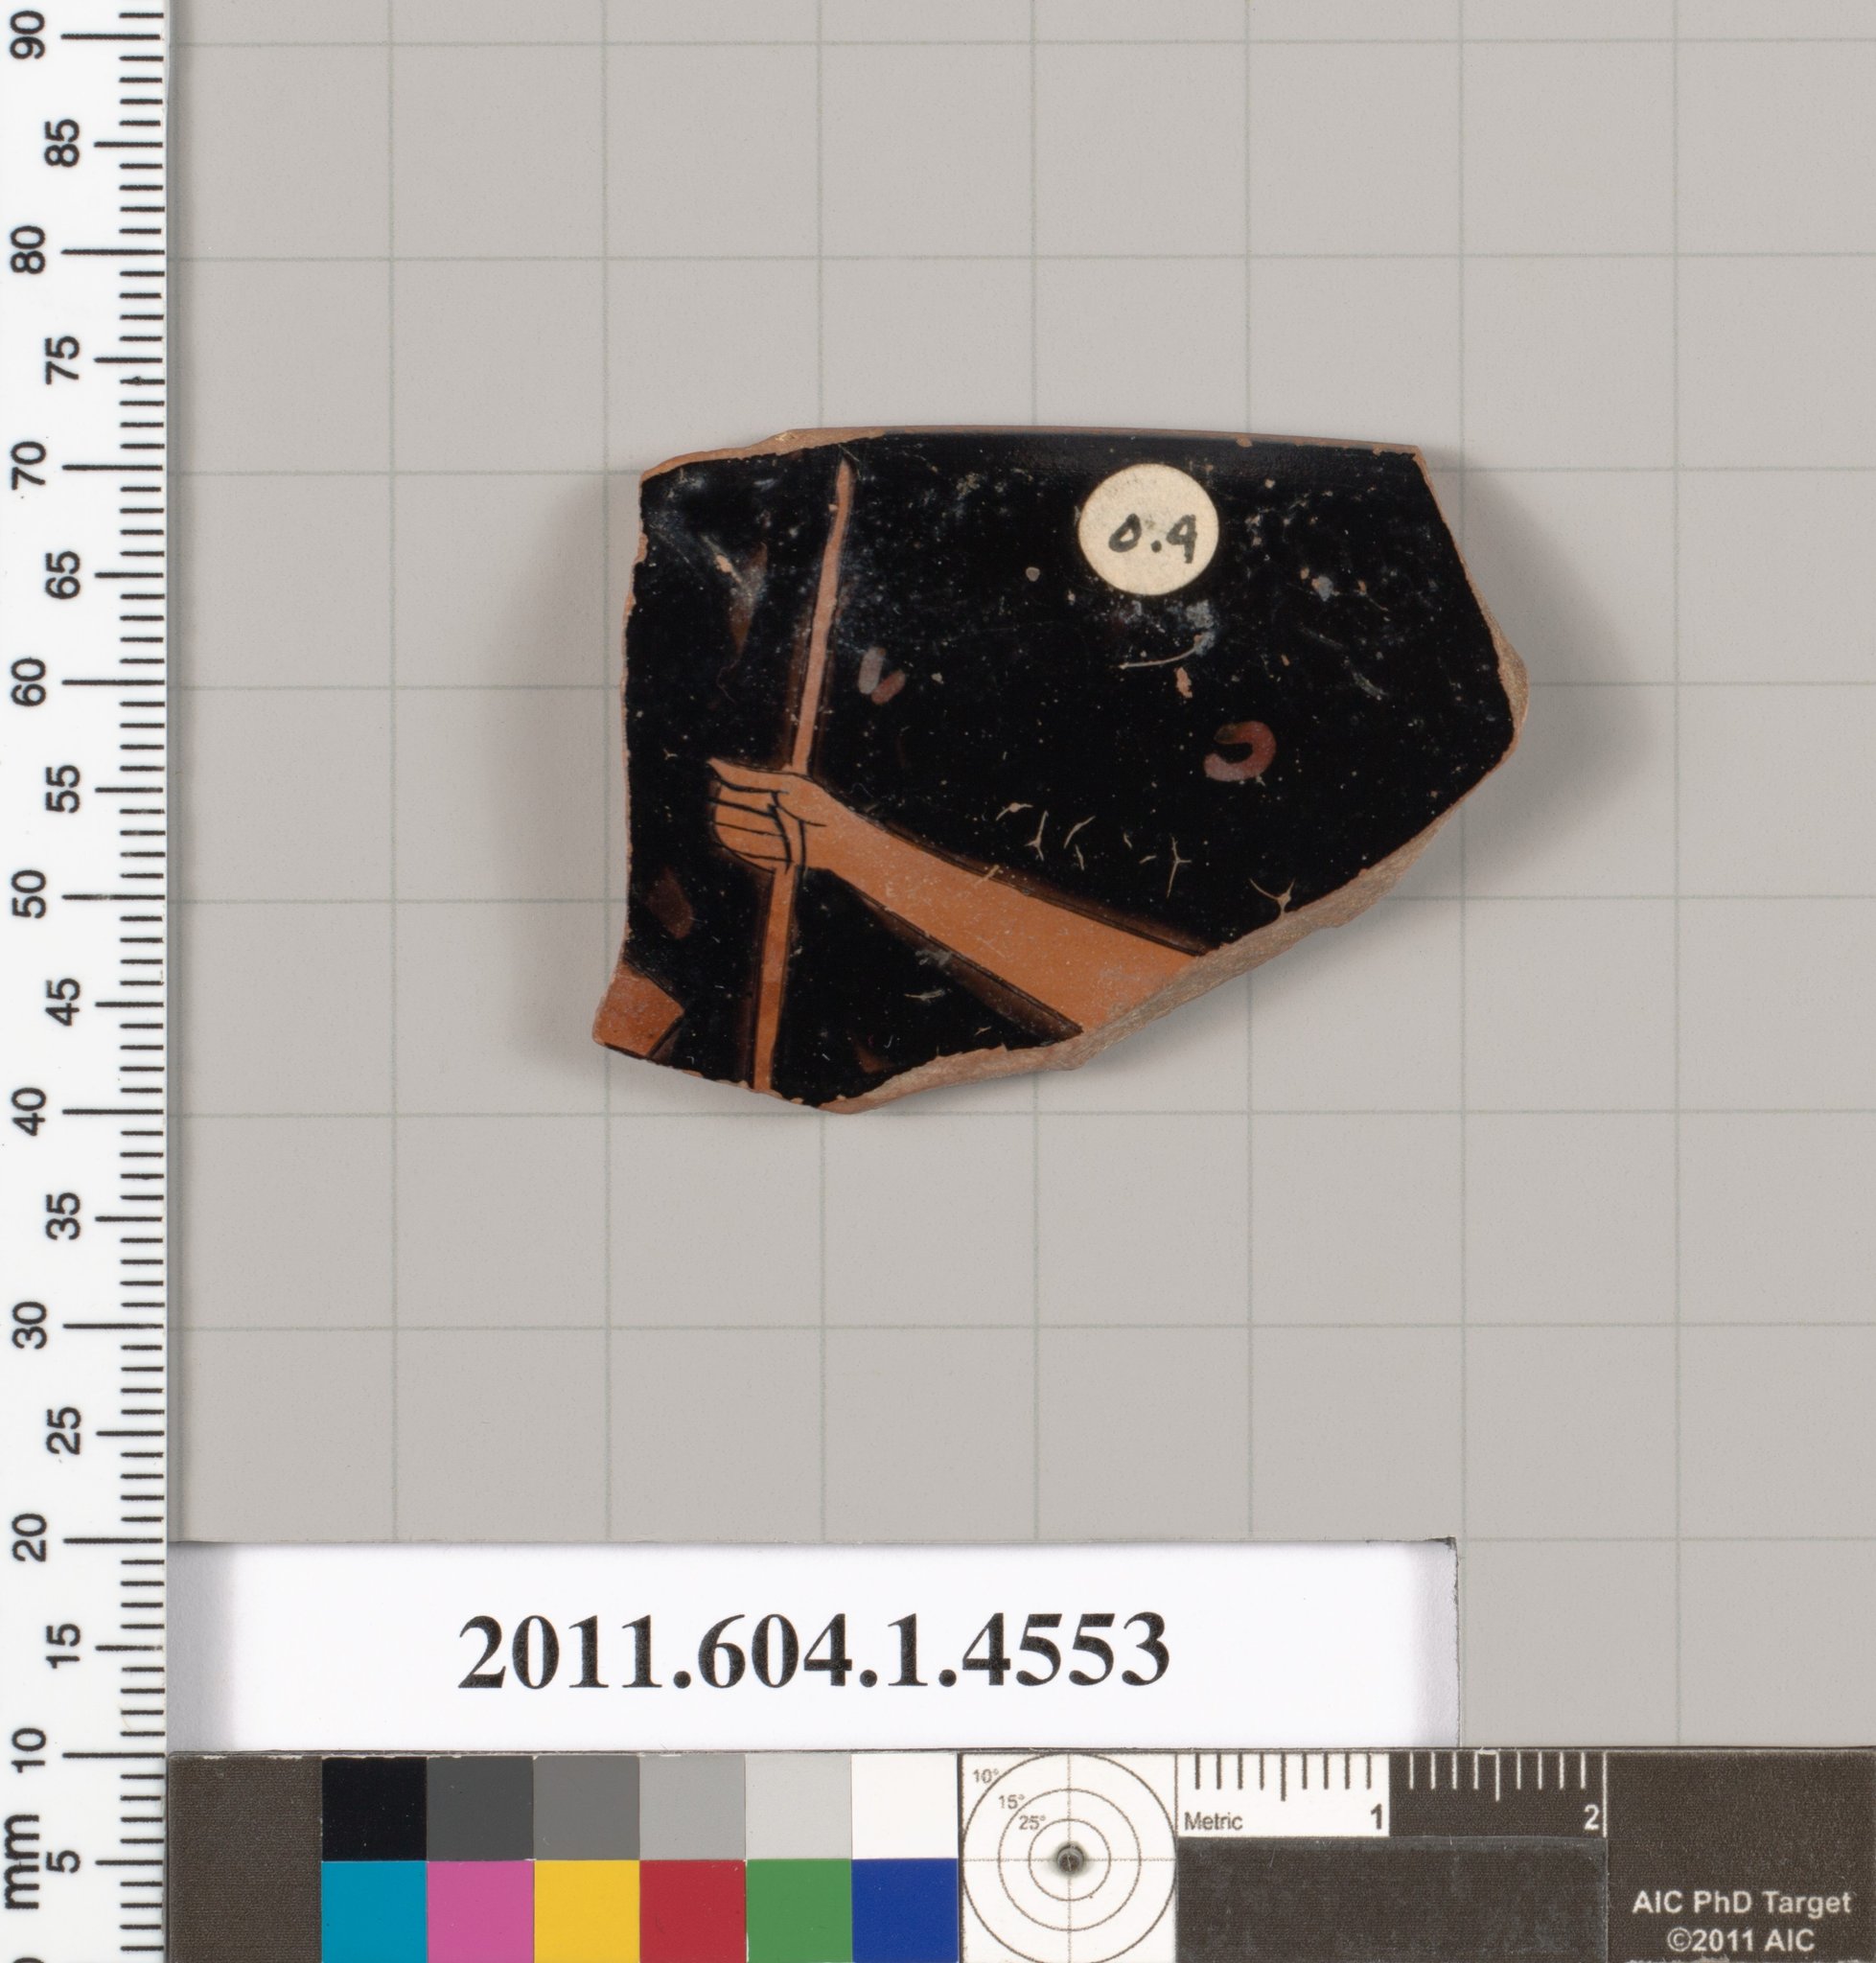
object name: kylix fragment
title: Terracotta rim fragment of a kylix (drinking cup)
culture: greek, attic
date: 500-480 BCE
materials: terracotta